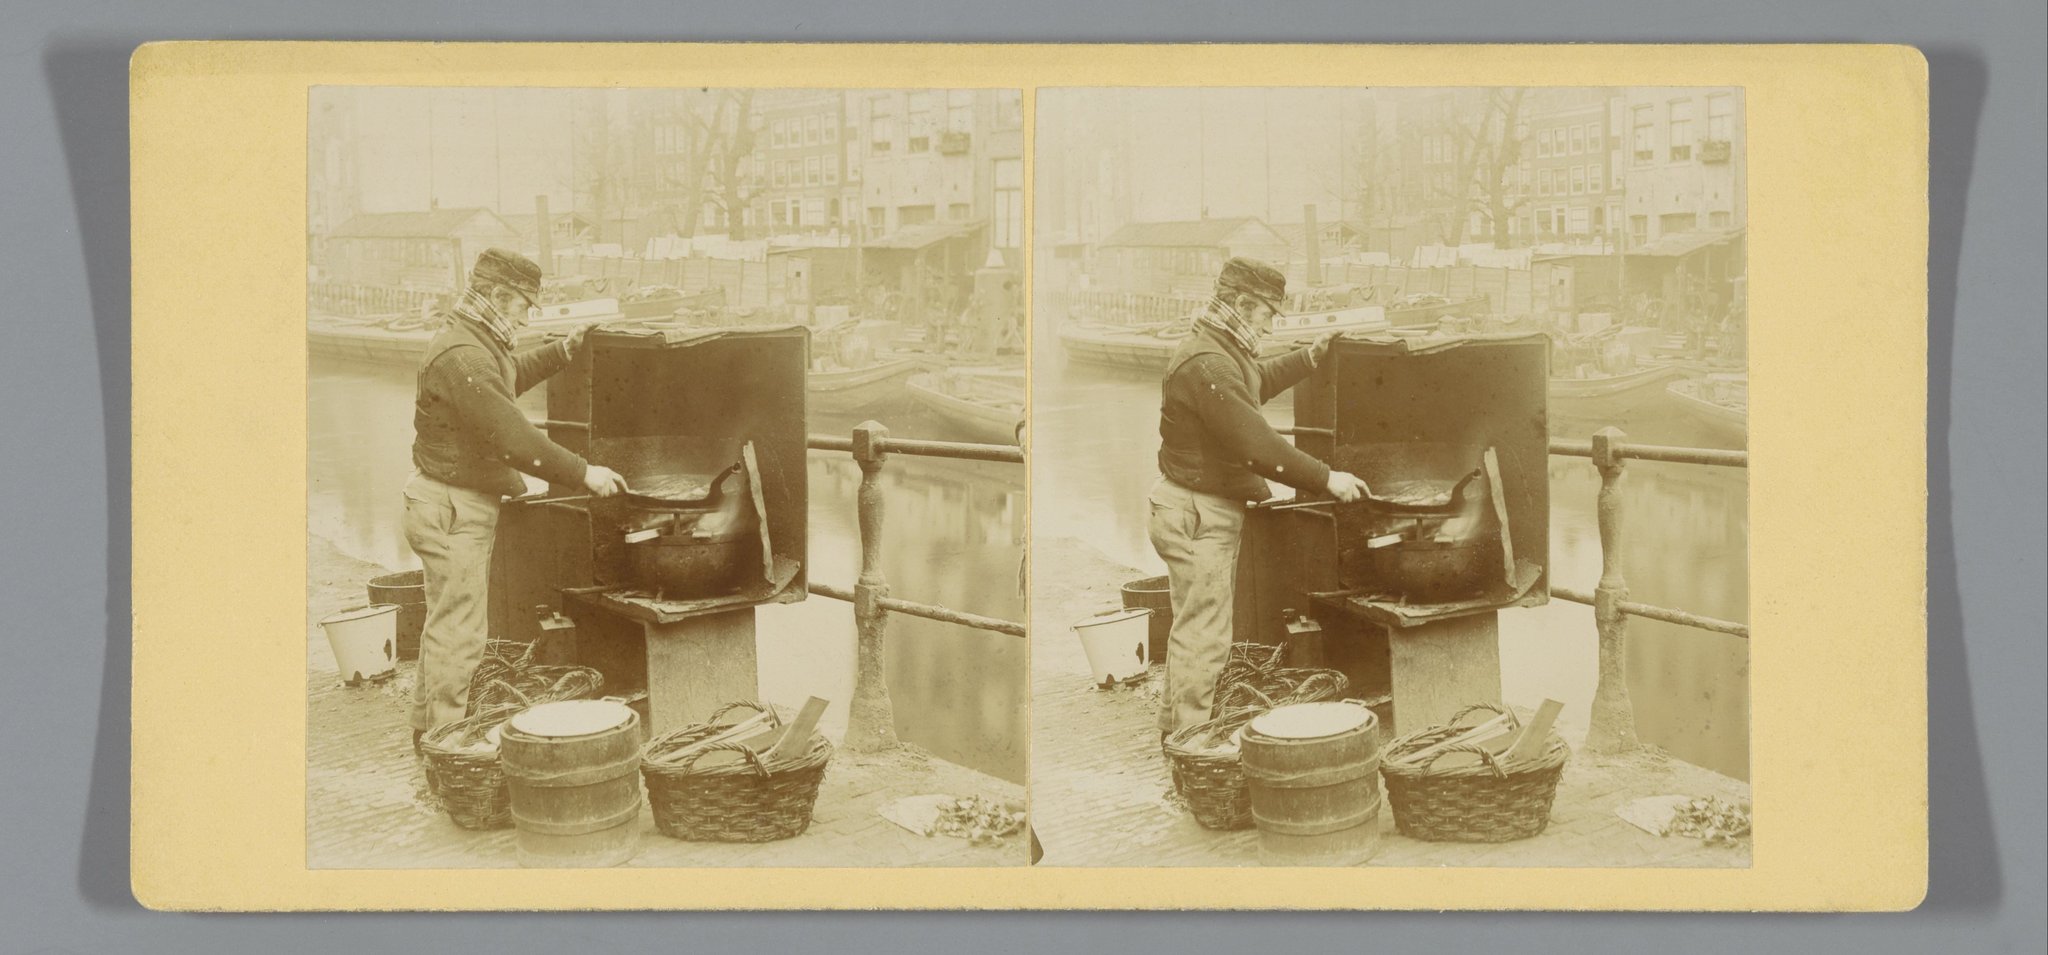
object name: stereograph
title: Oud Holland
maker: Anonymous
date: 1897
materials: paper, cardboard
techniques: gelatin silver print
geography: amsterdam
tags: fishes, frying - cc - in the open air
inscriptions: inscription: ‘Tentoonst. 1897’